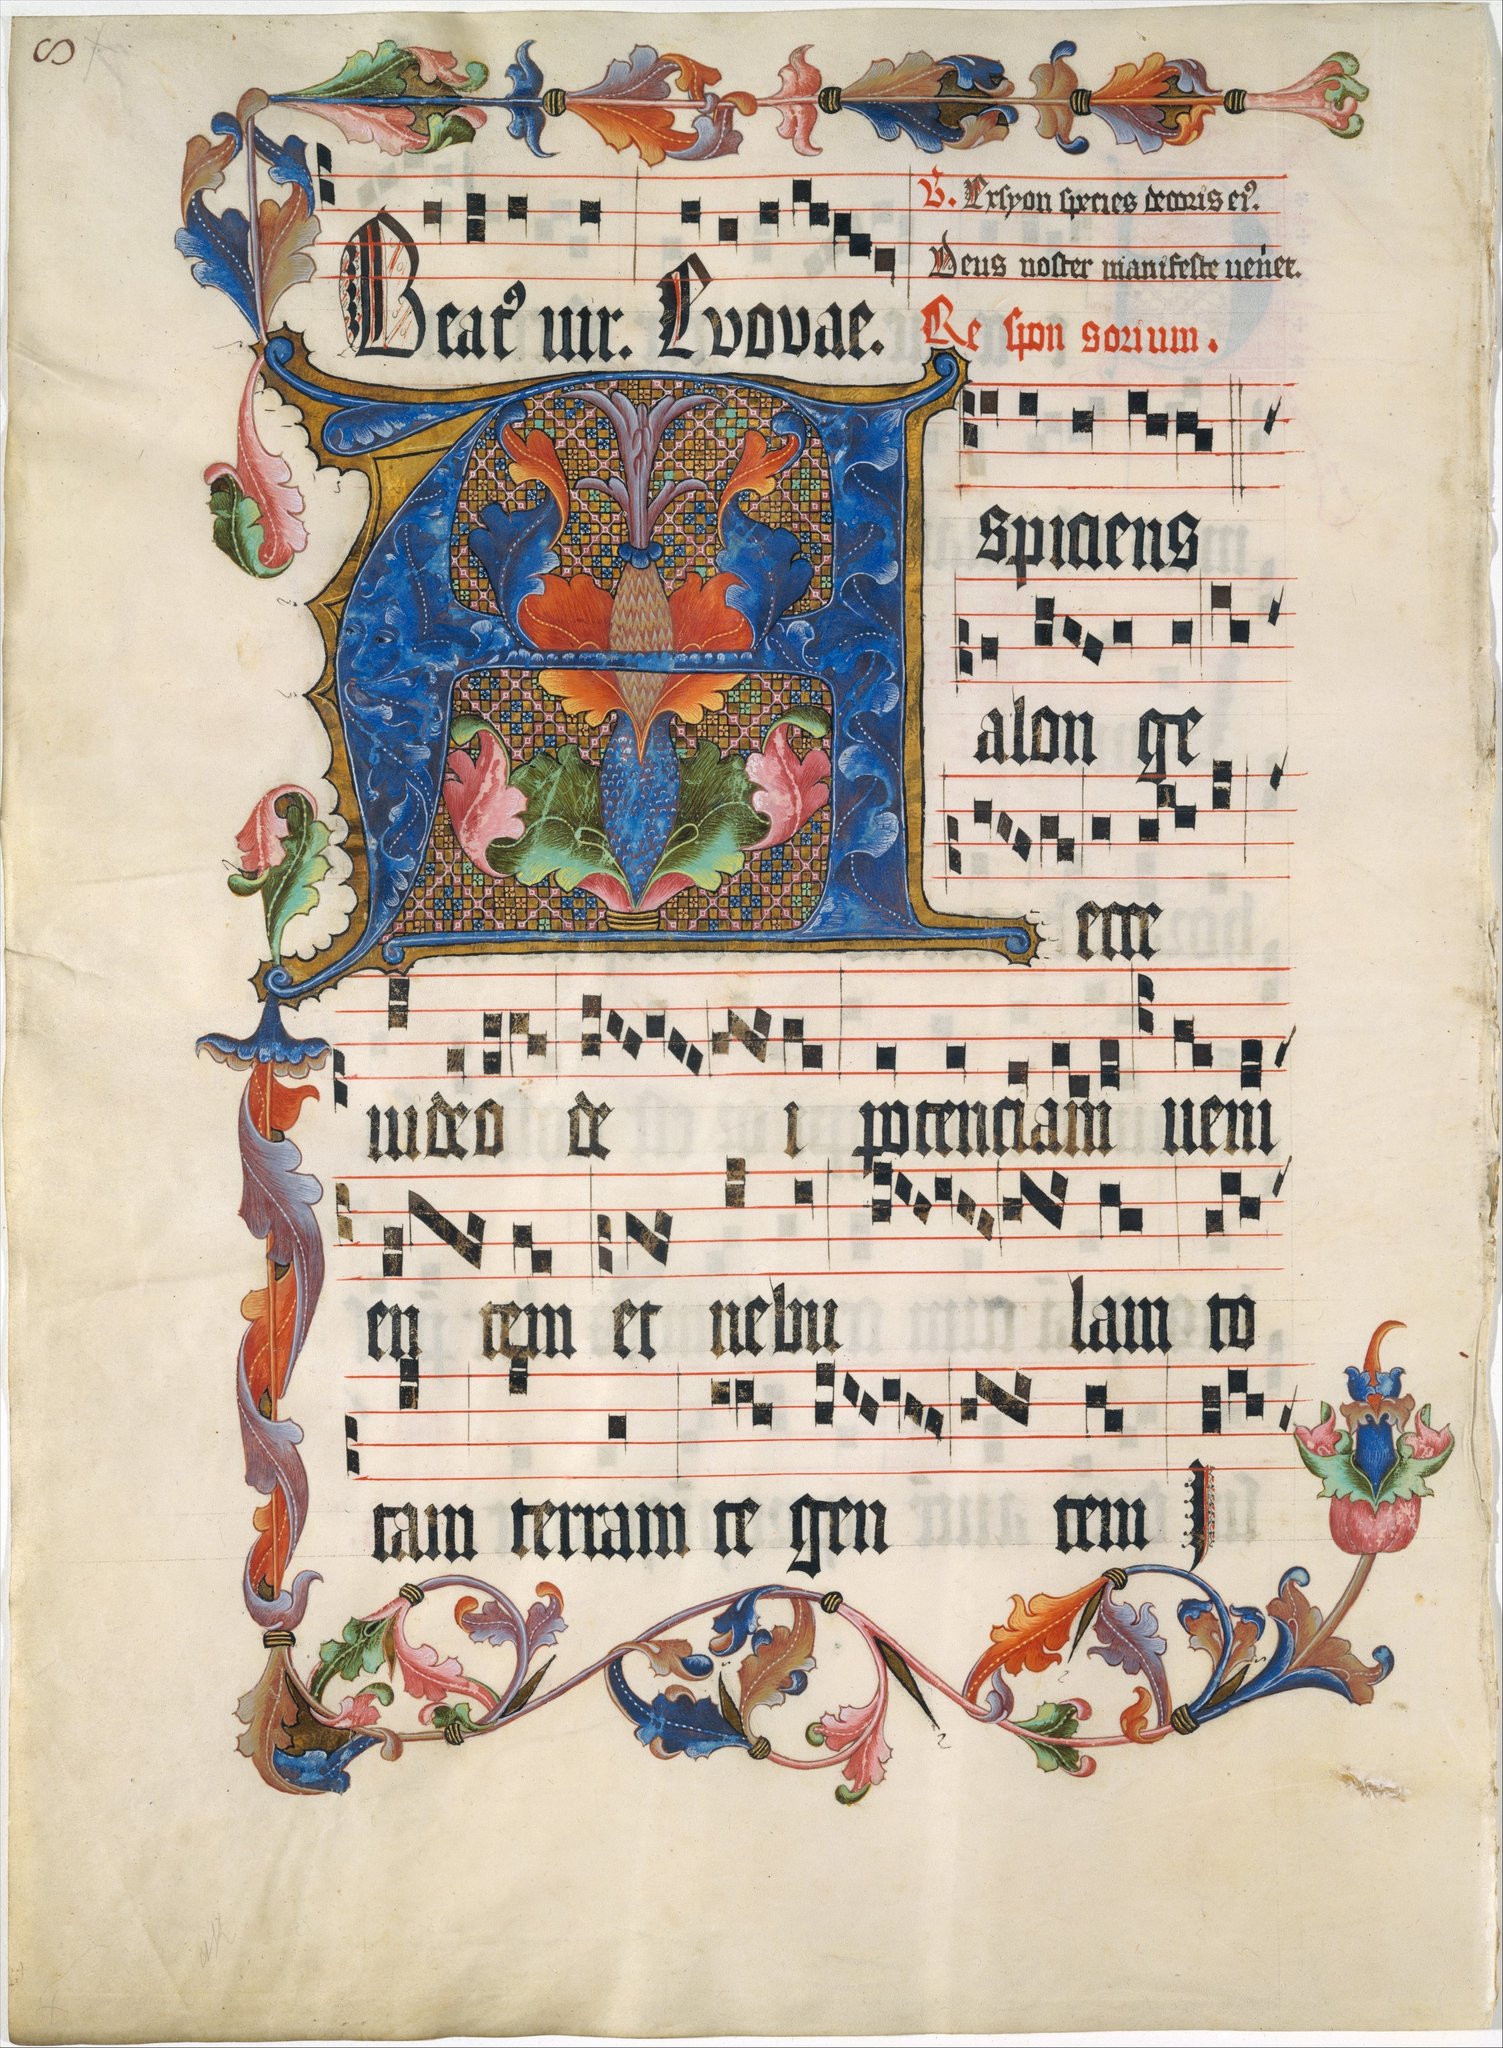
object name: antiphonary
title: Manuscript Leaf with Initial A, from an Antiphonary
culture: german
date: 1425-1450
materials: ink, metal leaf, parchment, paint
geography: germany